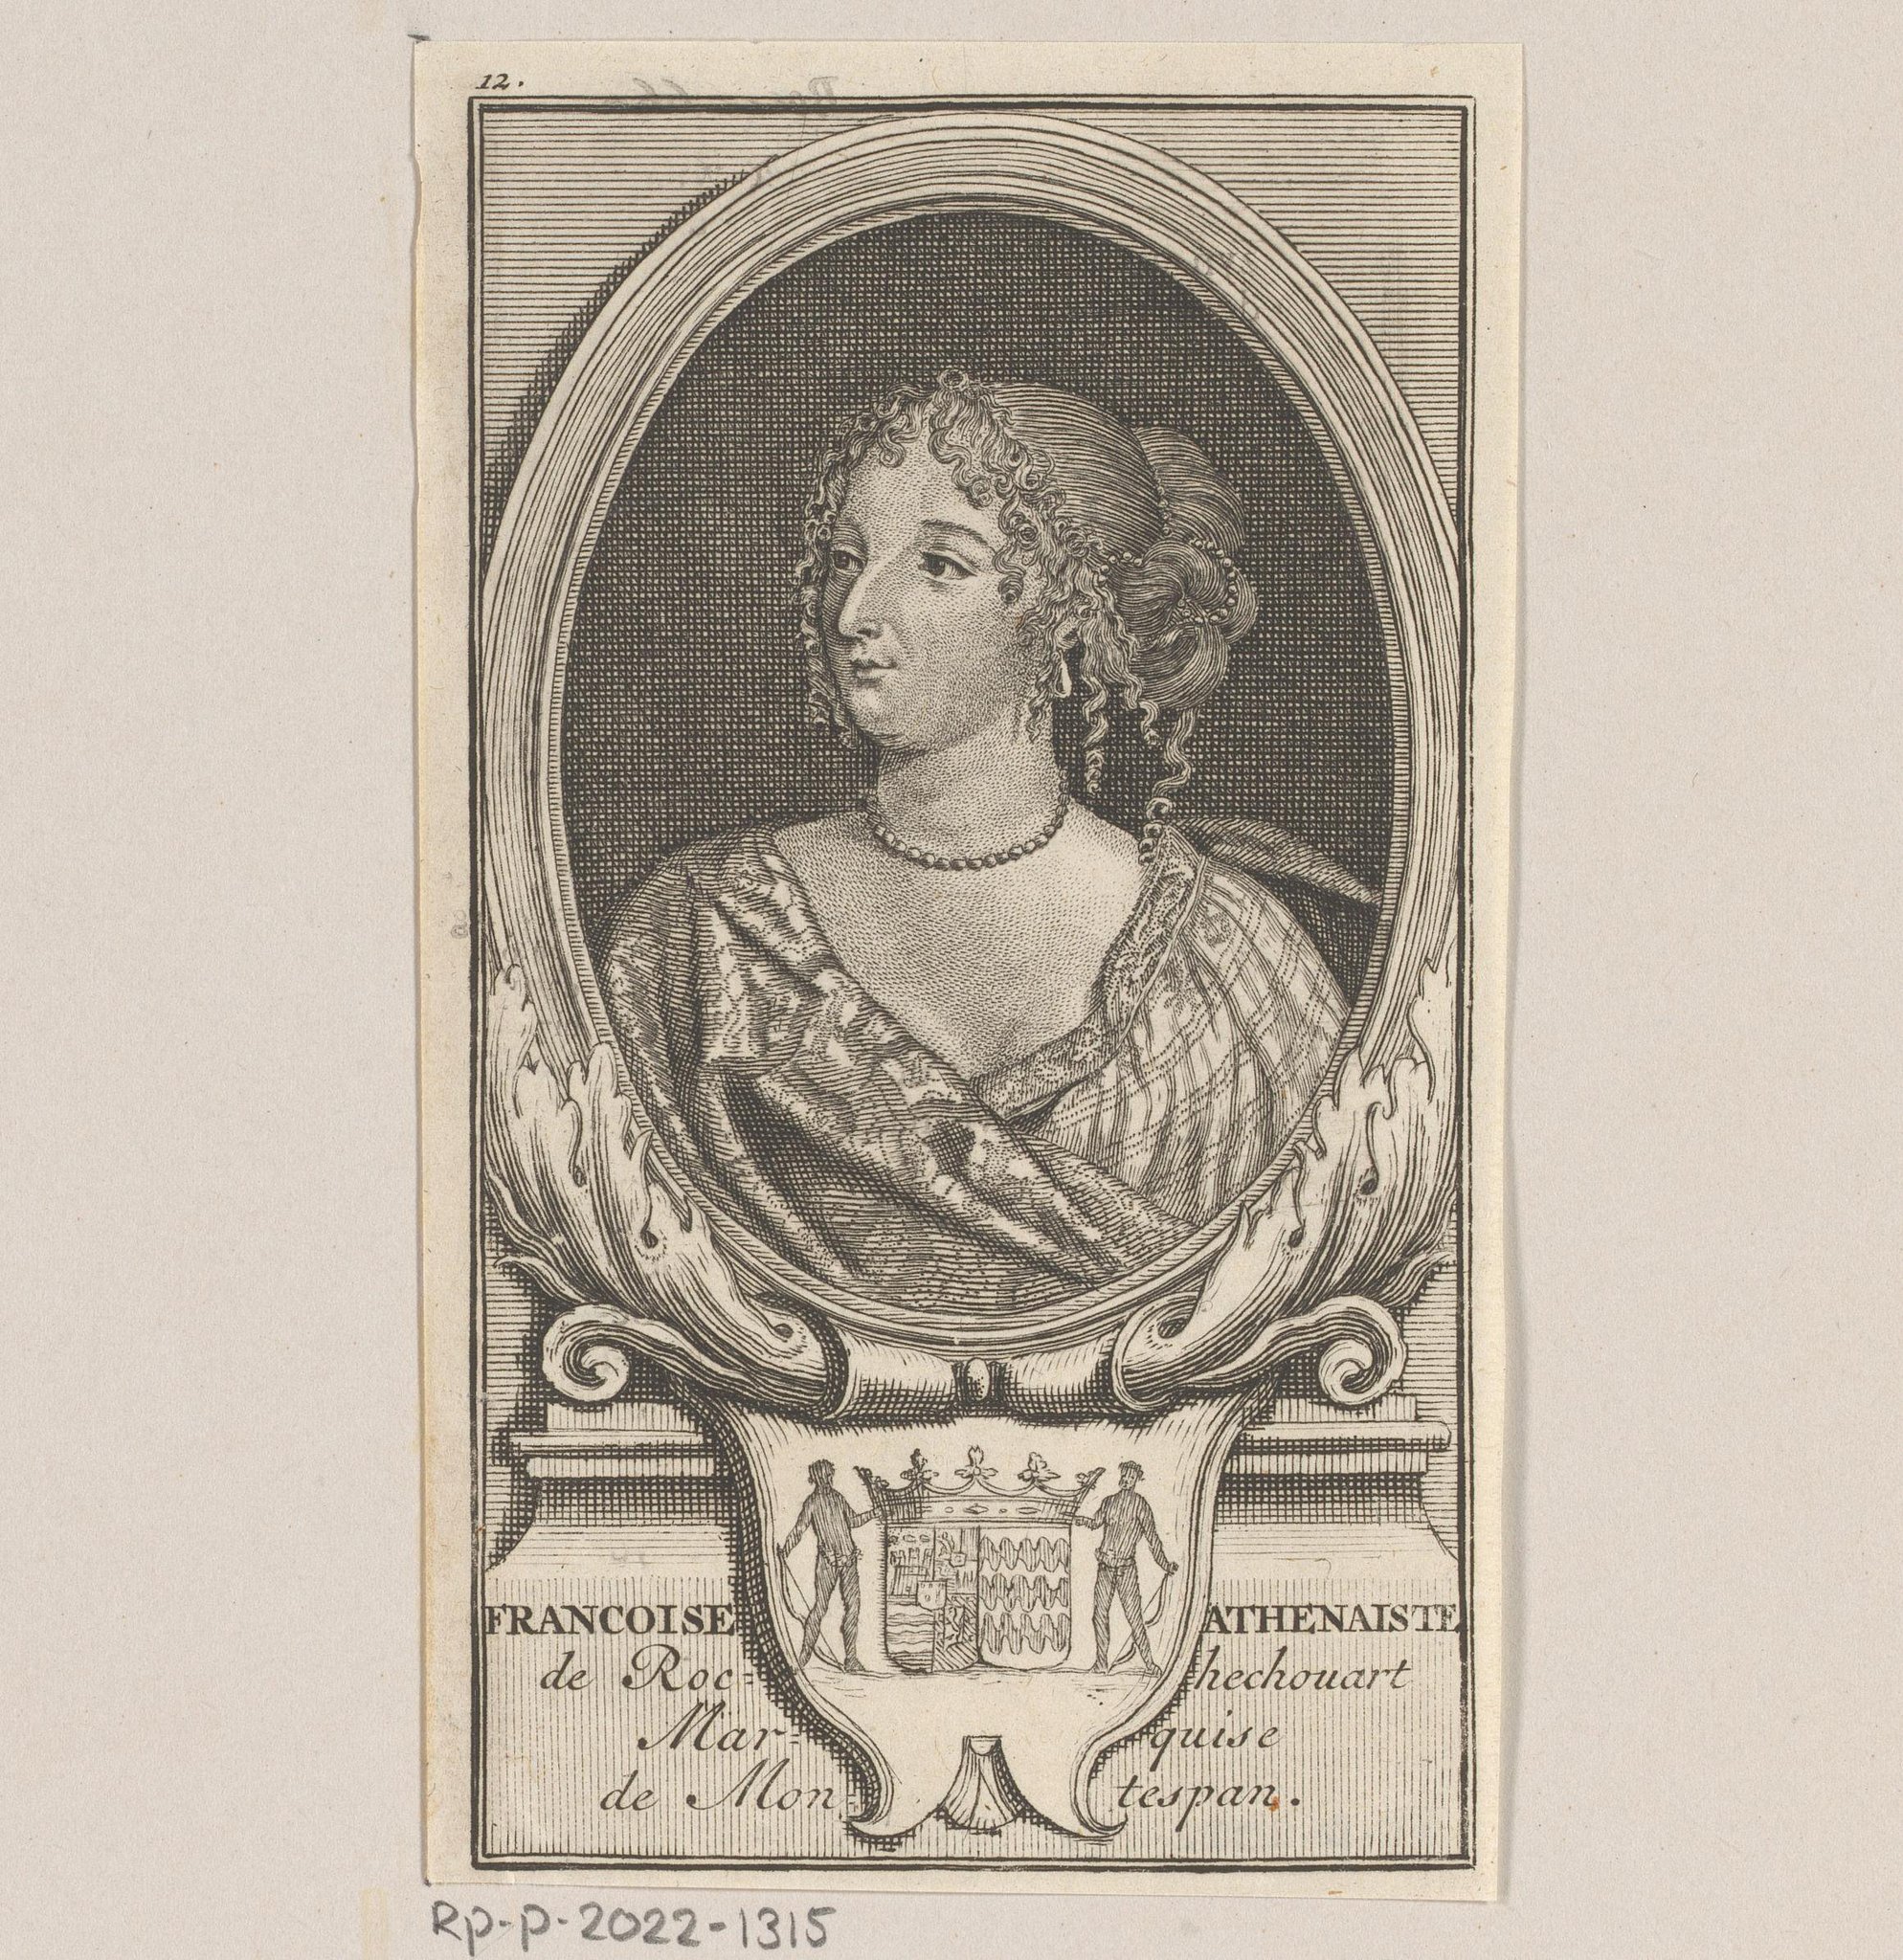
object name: print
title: Portret van Madame de Montespan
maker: Anonymous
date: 1718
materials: paper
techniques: engraving, etching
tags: françoise-athénaïs (marquise de montespan), historical persons - bb - woman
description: Prent waarschijnlijk uit: H.P.D.L.D.E.D. Historie der regeringen van Lodewyk den XIV, (...). Amsterdam: Compagnie, 1718.